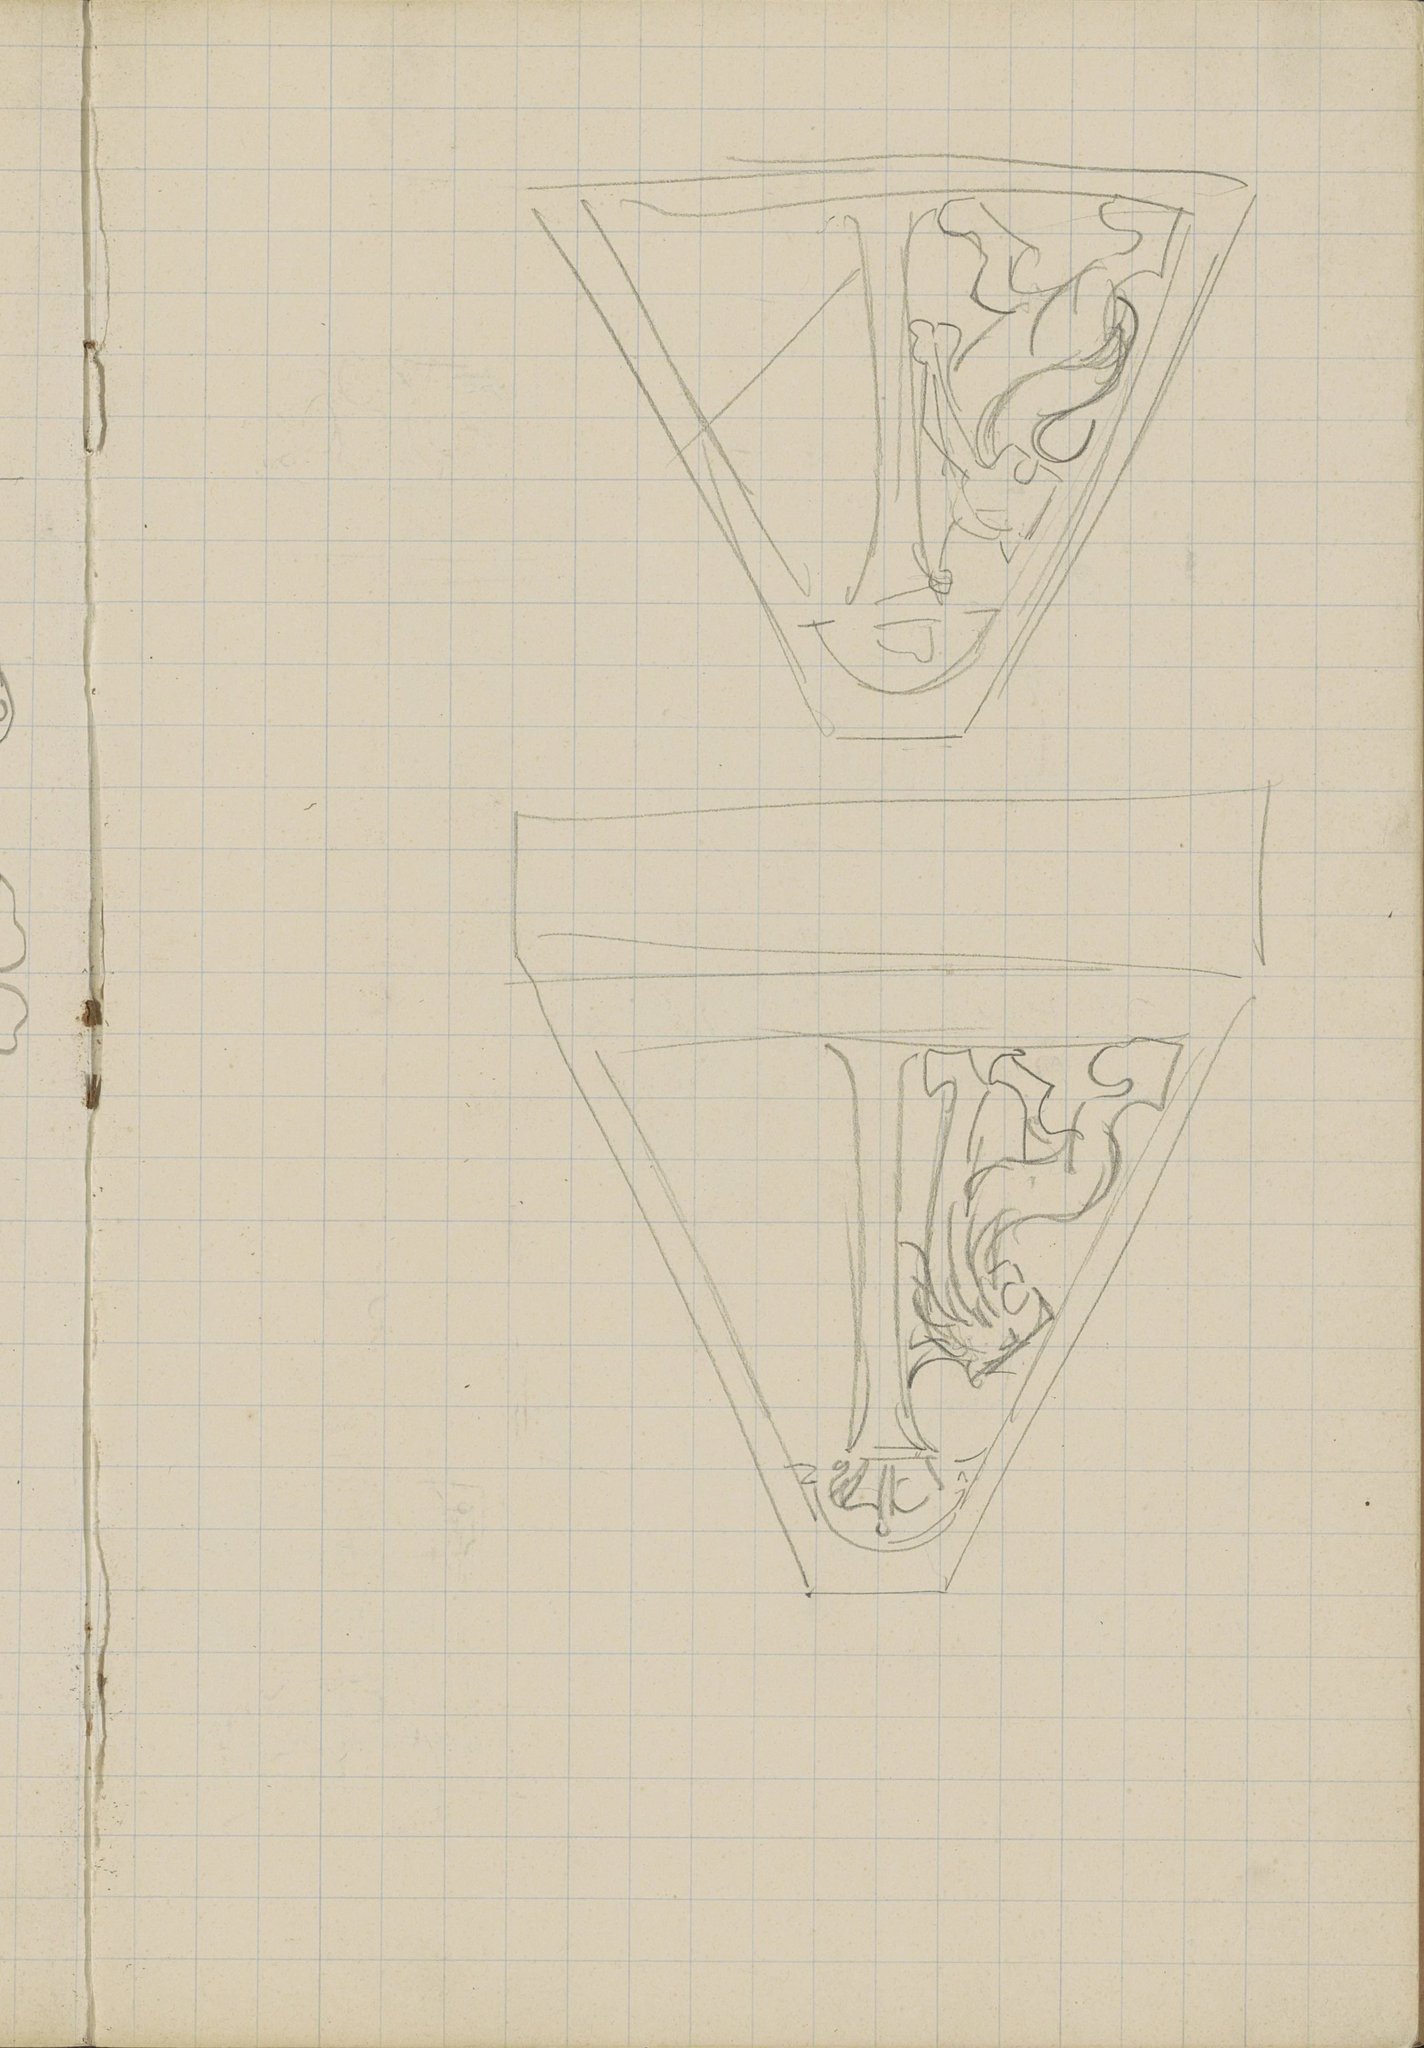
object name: sketchbook leaf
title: Driehoekige ornamenten met een floraal motief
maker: carel adolph lion cachet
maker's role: draughtsman, print maker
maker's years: 1864-1945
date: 1925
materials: pencil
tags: flowers ~ ornament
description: Blad 6 recto uit een schetsboek met 11 bladen.